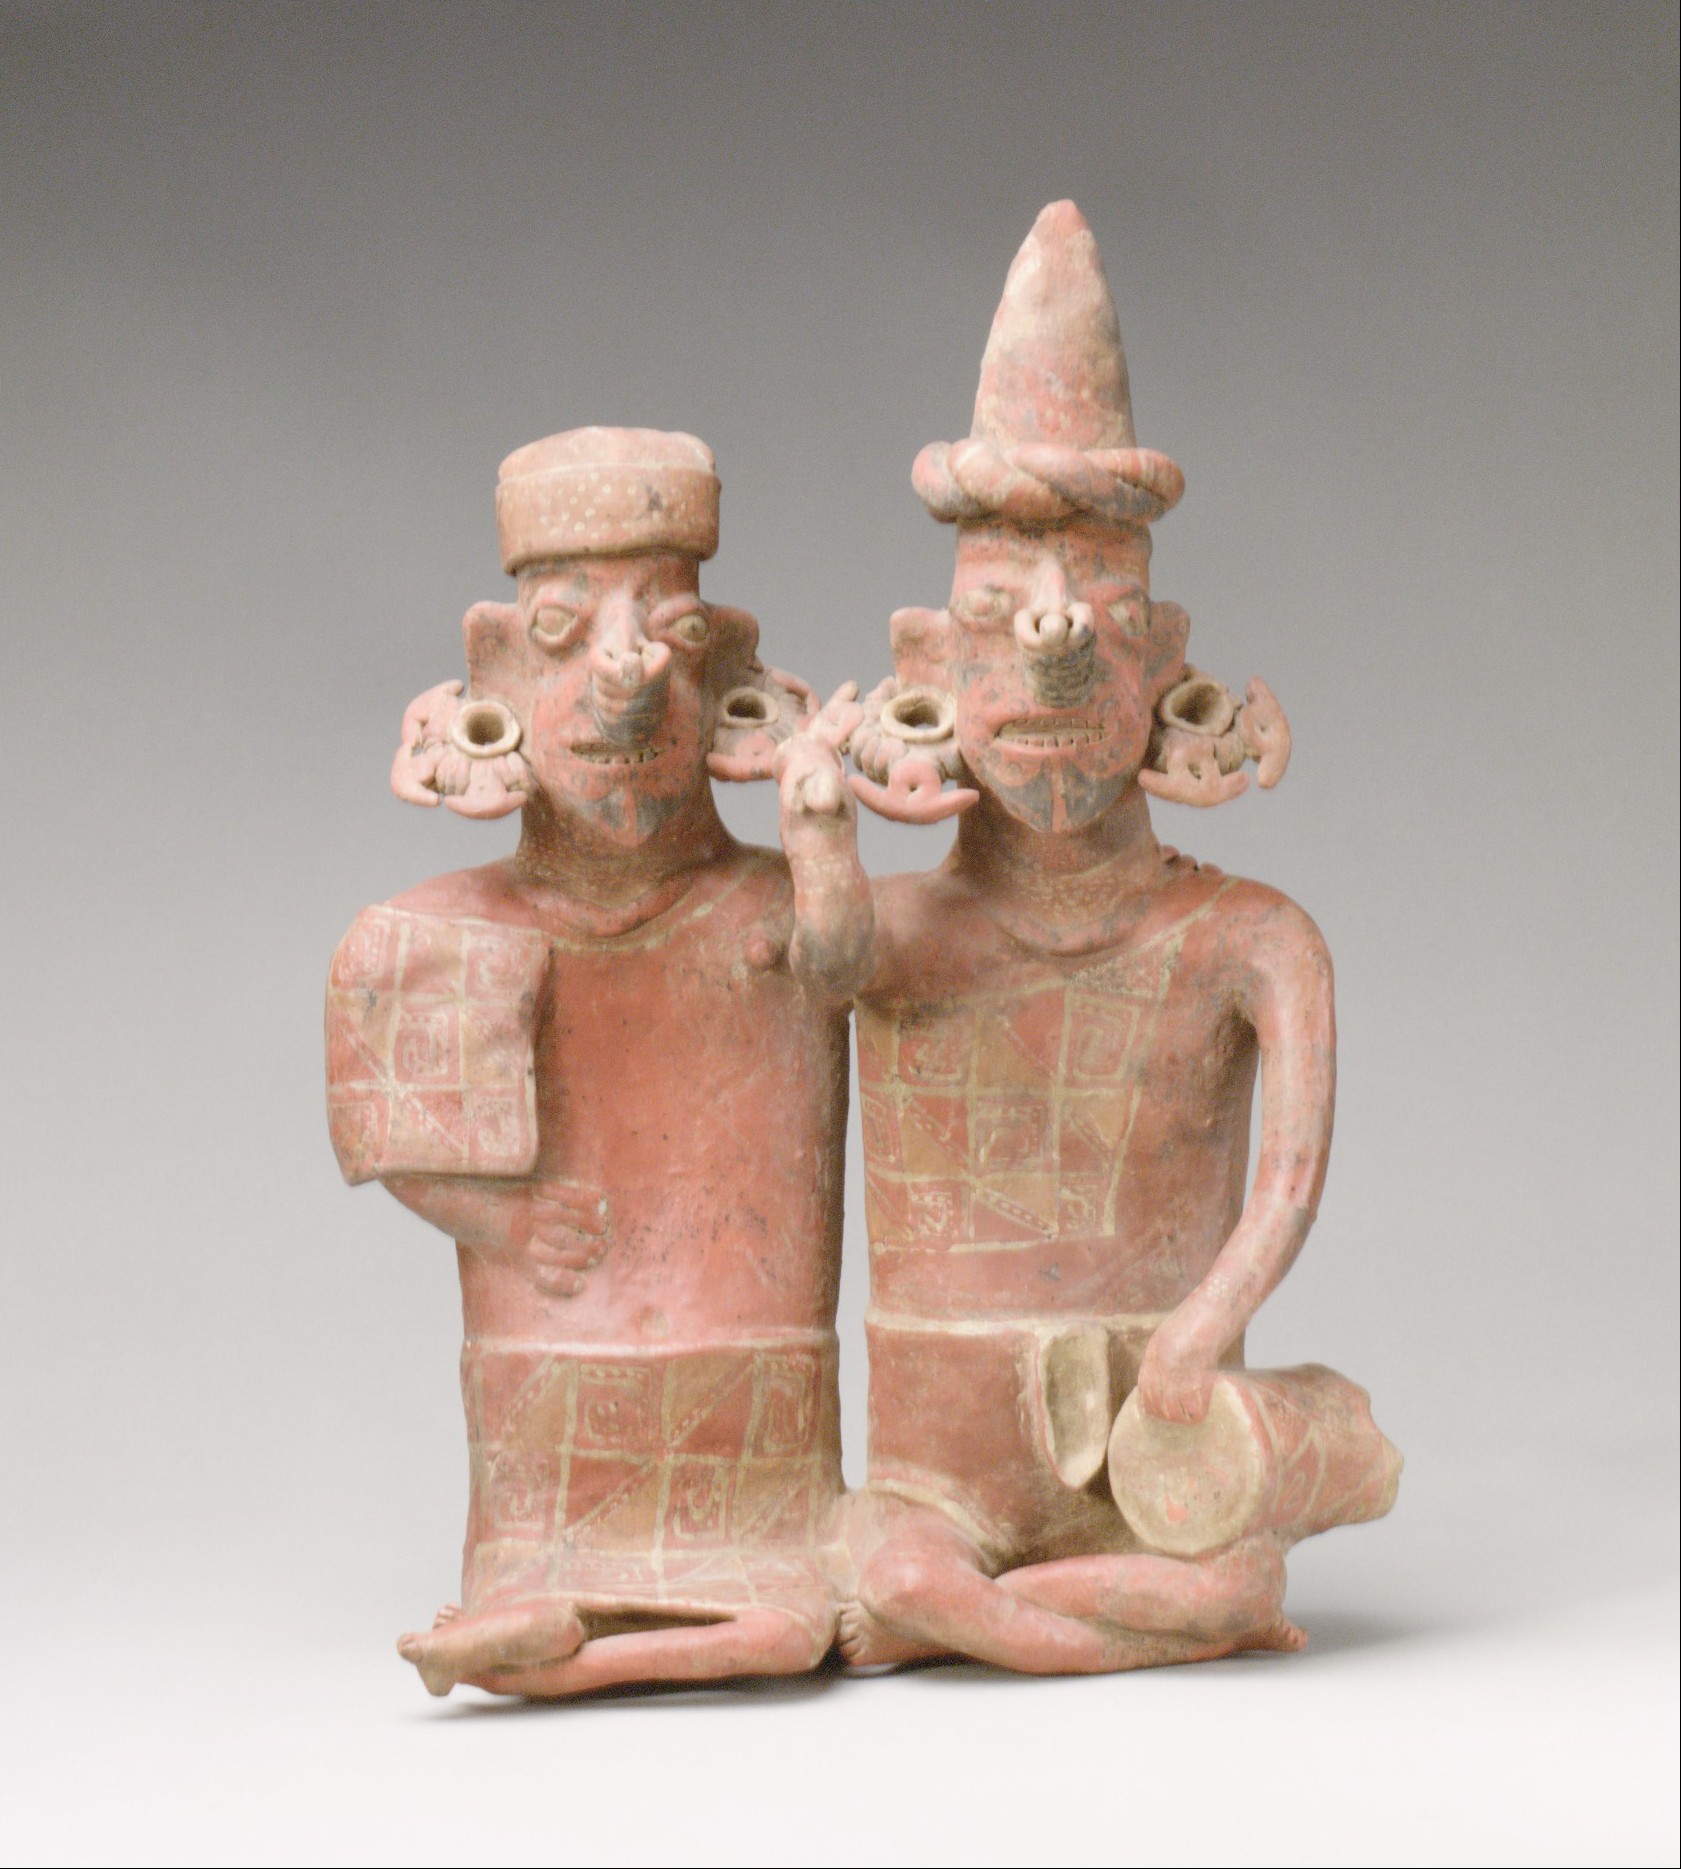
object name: figure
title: Pair of Figures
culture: ixtlán del río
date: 200 BCE-200 CE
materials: ceramic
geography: mexico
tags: men,women